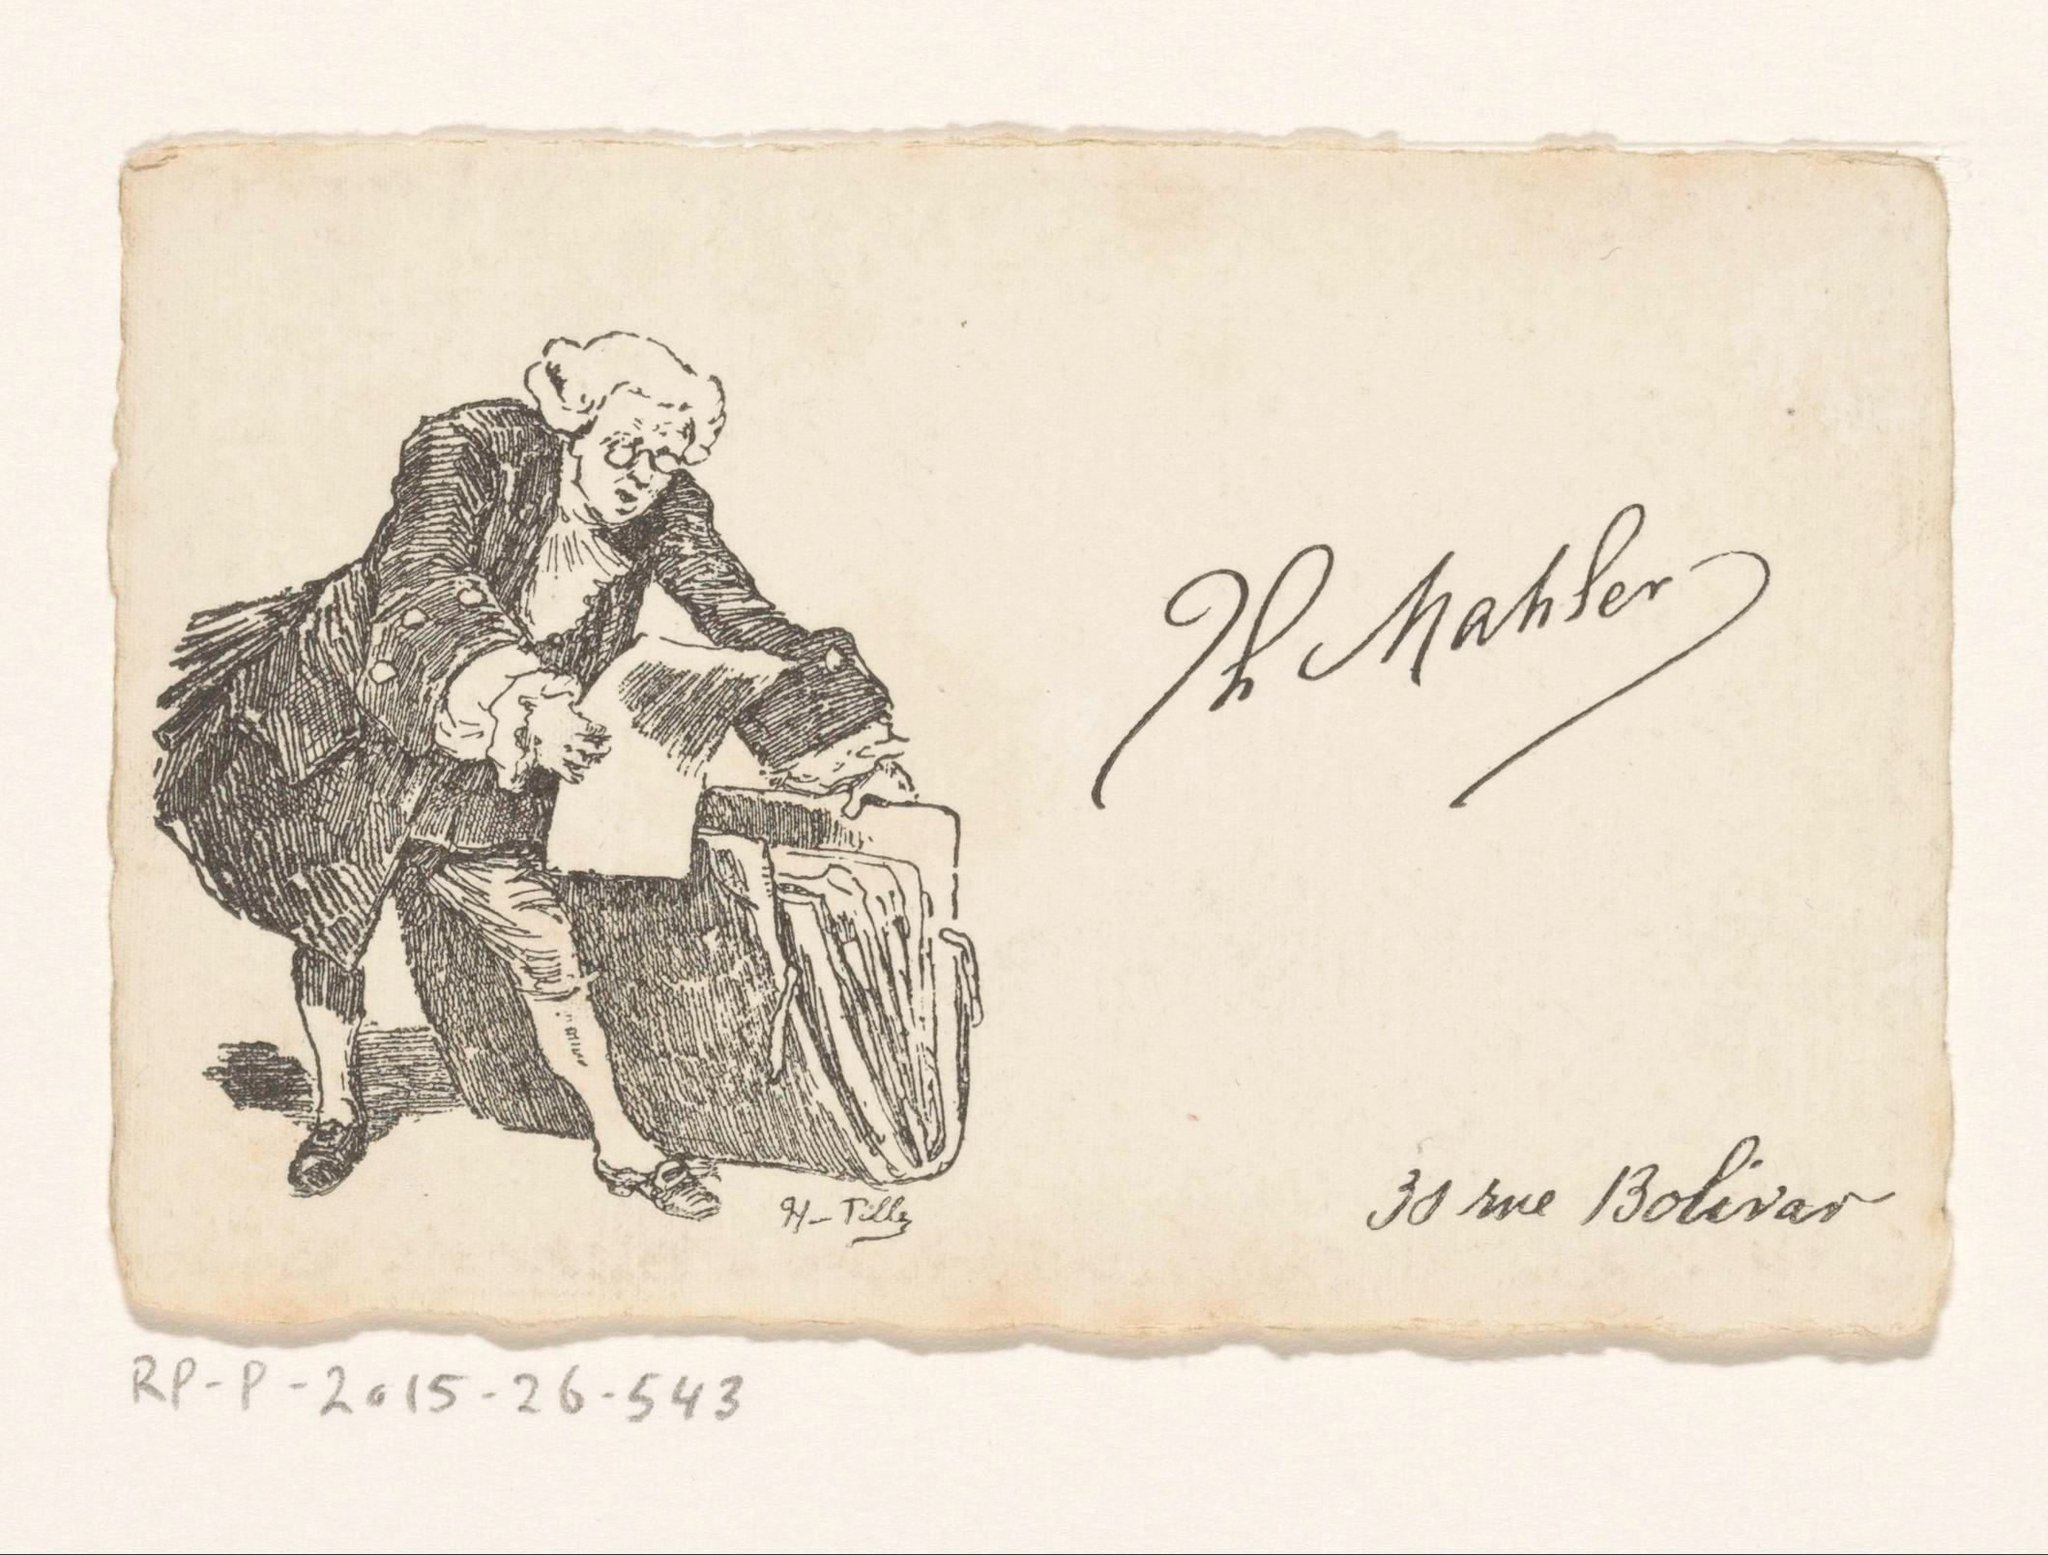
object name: visiting card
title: Visitekaartje van J.H. Mahler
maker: h. tilly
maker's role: print maker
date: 1900-1930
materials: cardboard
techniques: printing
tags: print, e.g.: engraving, etching, lithograph, art collecting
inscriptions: collector's mark: Lugt 2228, collector's mark: Lugt 4779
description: Een man in achttiende-eeuwse kleding naast een portfolio, een blad in zijn hand.